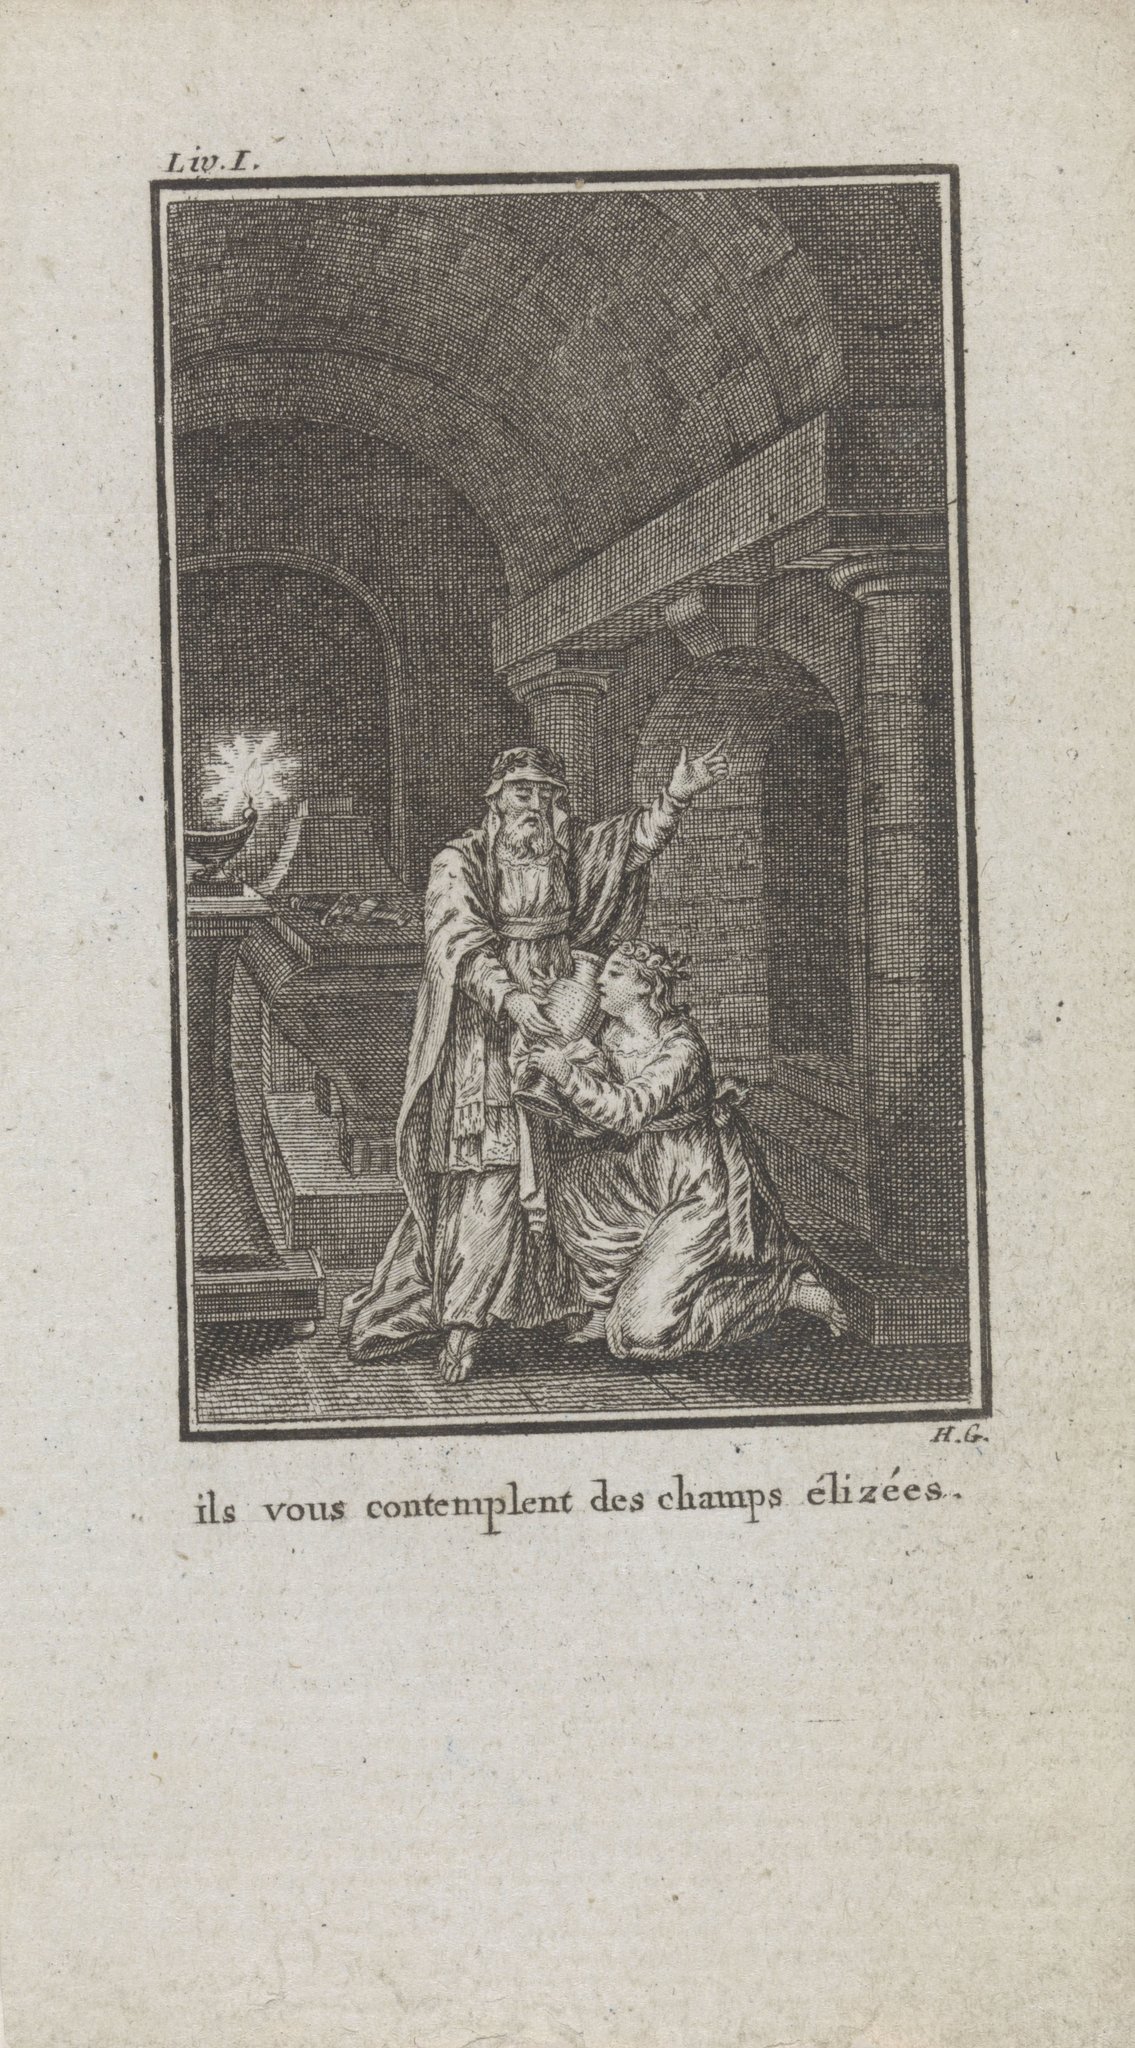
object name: print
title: Tullus vertelt Numa over zijn vader en moeder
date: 1790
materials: paper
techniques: engraving, letterpress printing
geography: brussels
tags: grave, tomb, male literary characters (with name)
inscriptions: collector's mark: Lugt 2228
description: Numa knielt en kust de urn van zijn moeder in de grafkelder van zijn ouders, terwijl de hogepriester Tullus over hun leven vertelt. Met een Frans onderschrift.